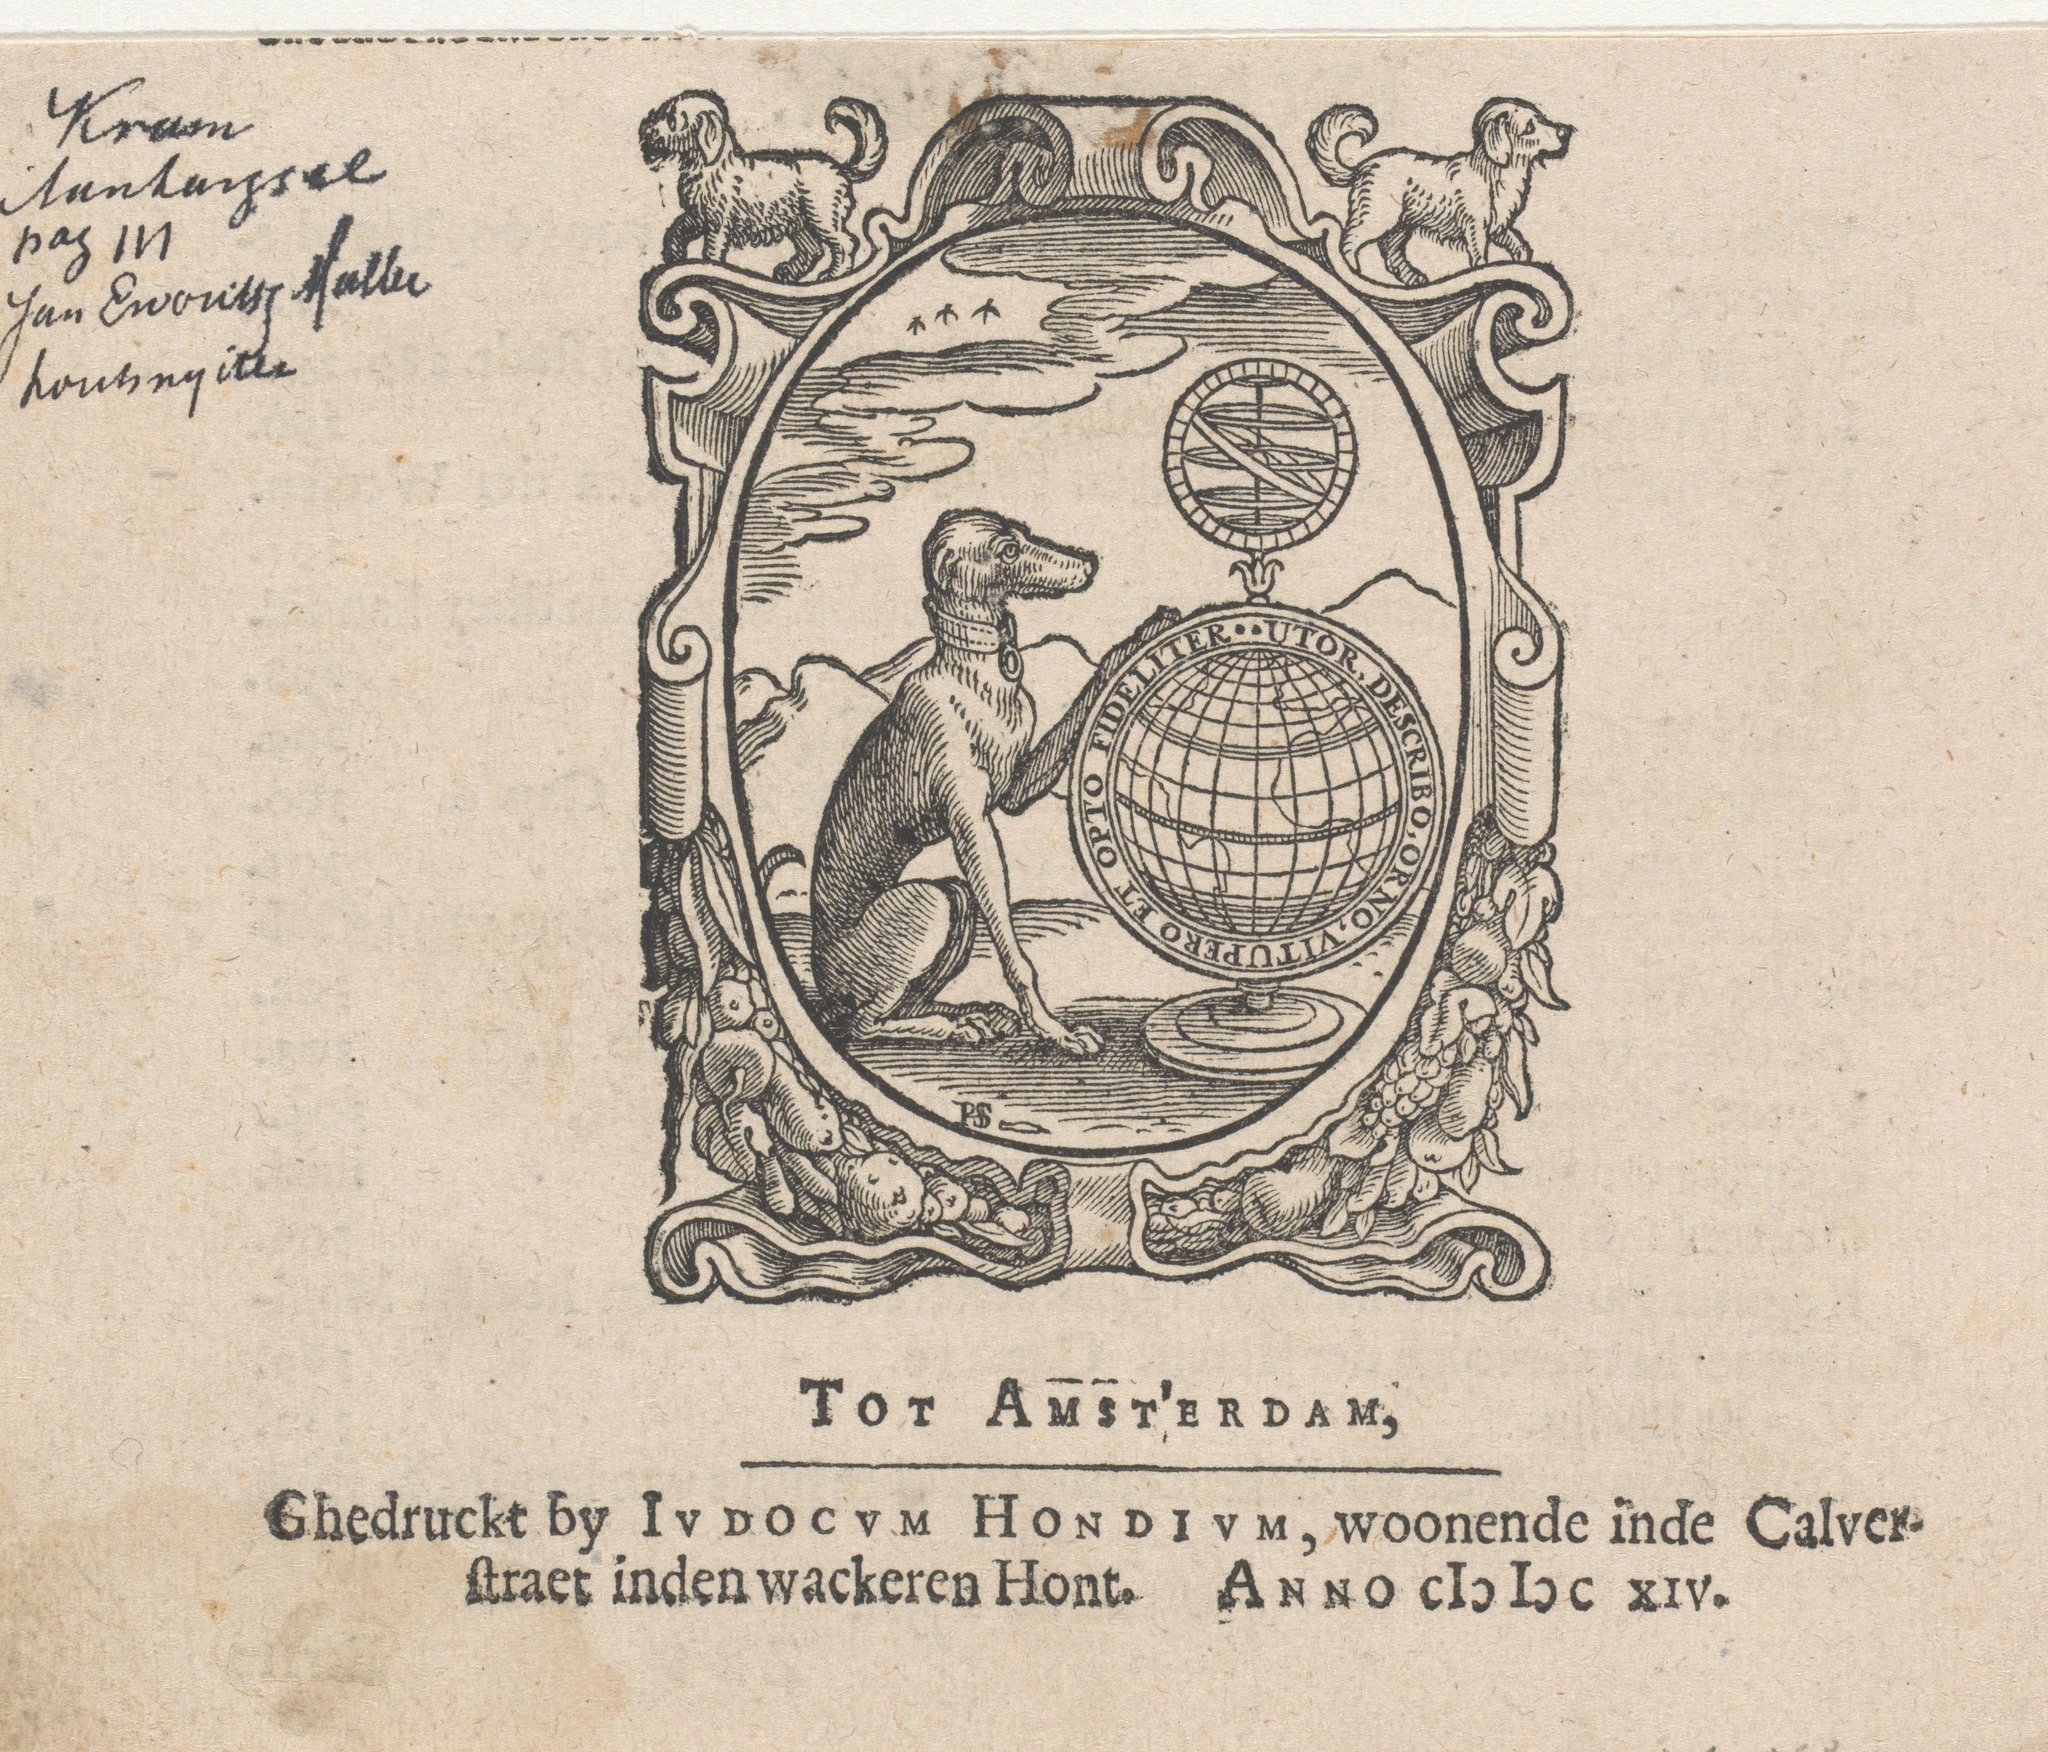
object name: print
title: Titelvignet voor: Johannes Isacius Pontanus, Historische beschrĳvinghe der seer wĳt beroemde coop-stadt Amsterdam, 1614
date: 1614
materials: paper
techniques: letterpress printing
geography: amsterdam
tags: globe, vignette, dog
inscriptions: collector's mark: Lugt 2228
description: Titelvignet voor: Pontanus, Johannes Isacius. Historische beschrĳvinghe der seer wĳt beroemde coop-stadt Amsterdam. Amsterdam: Jodocus Hondius, 1614.